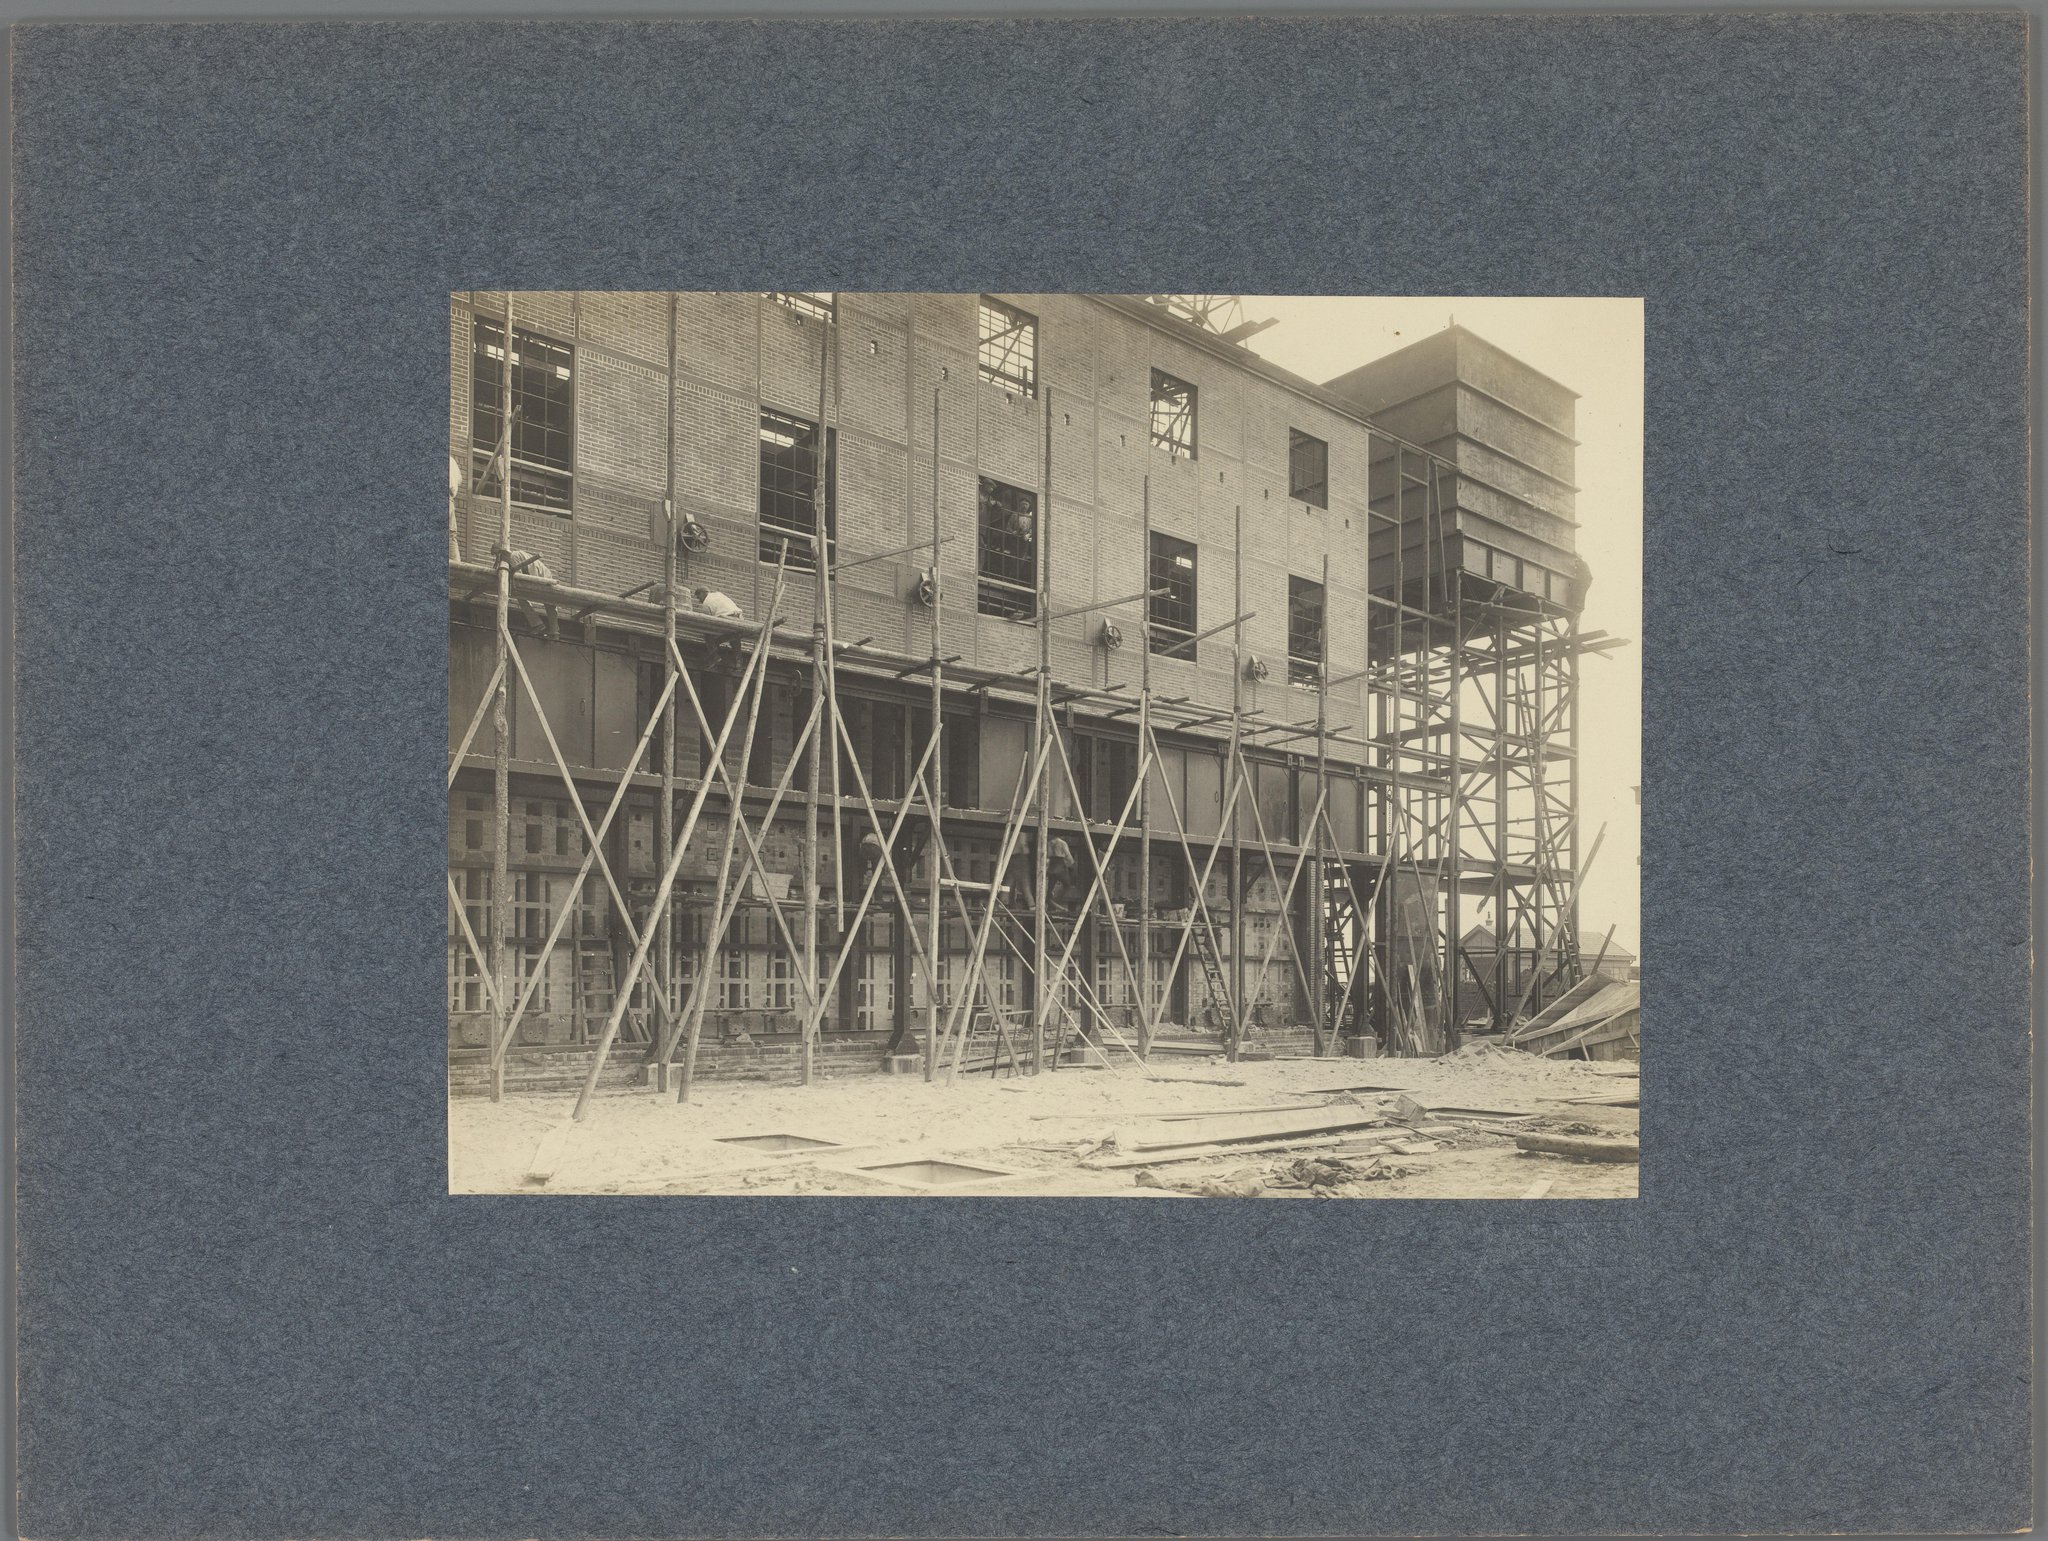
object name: photograph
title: Fabriek of opslagplaats in aanbouw, Rotterdam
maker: willem sr. bleuzé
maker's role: fotograaf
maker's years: 1873-1948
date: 1912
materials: paper, cardboard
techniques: gelatin silver print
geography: rotterdam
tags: warehouse (~ harbour), factory-building, building-site, rotterdam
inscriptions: address: ‘W. BLEUZÉ/ ROTTERDAM/ JONKER FRANSSTRAAT 66’, inscription: ‘25 juli 1912’